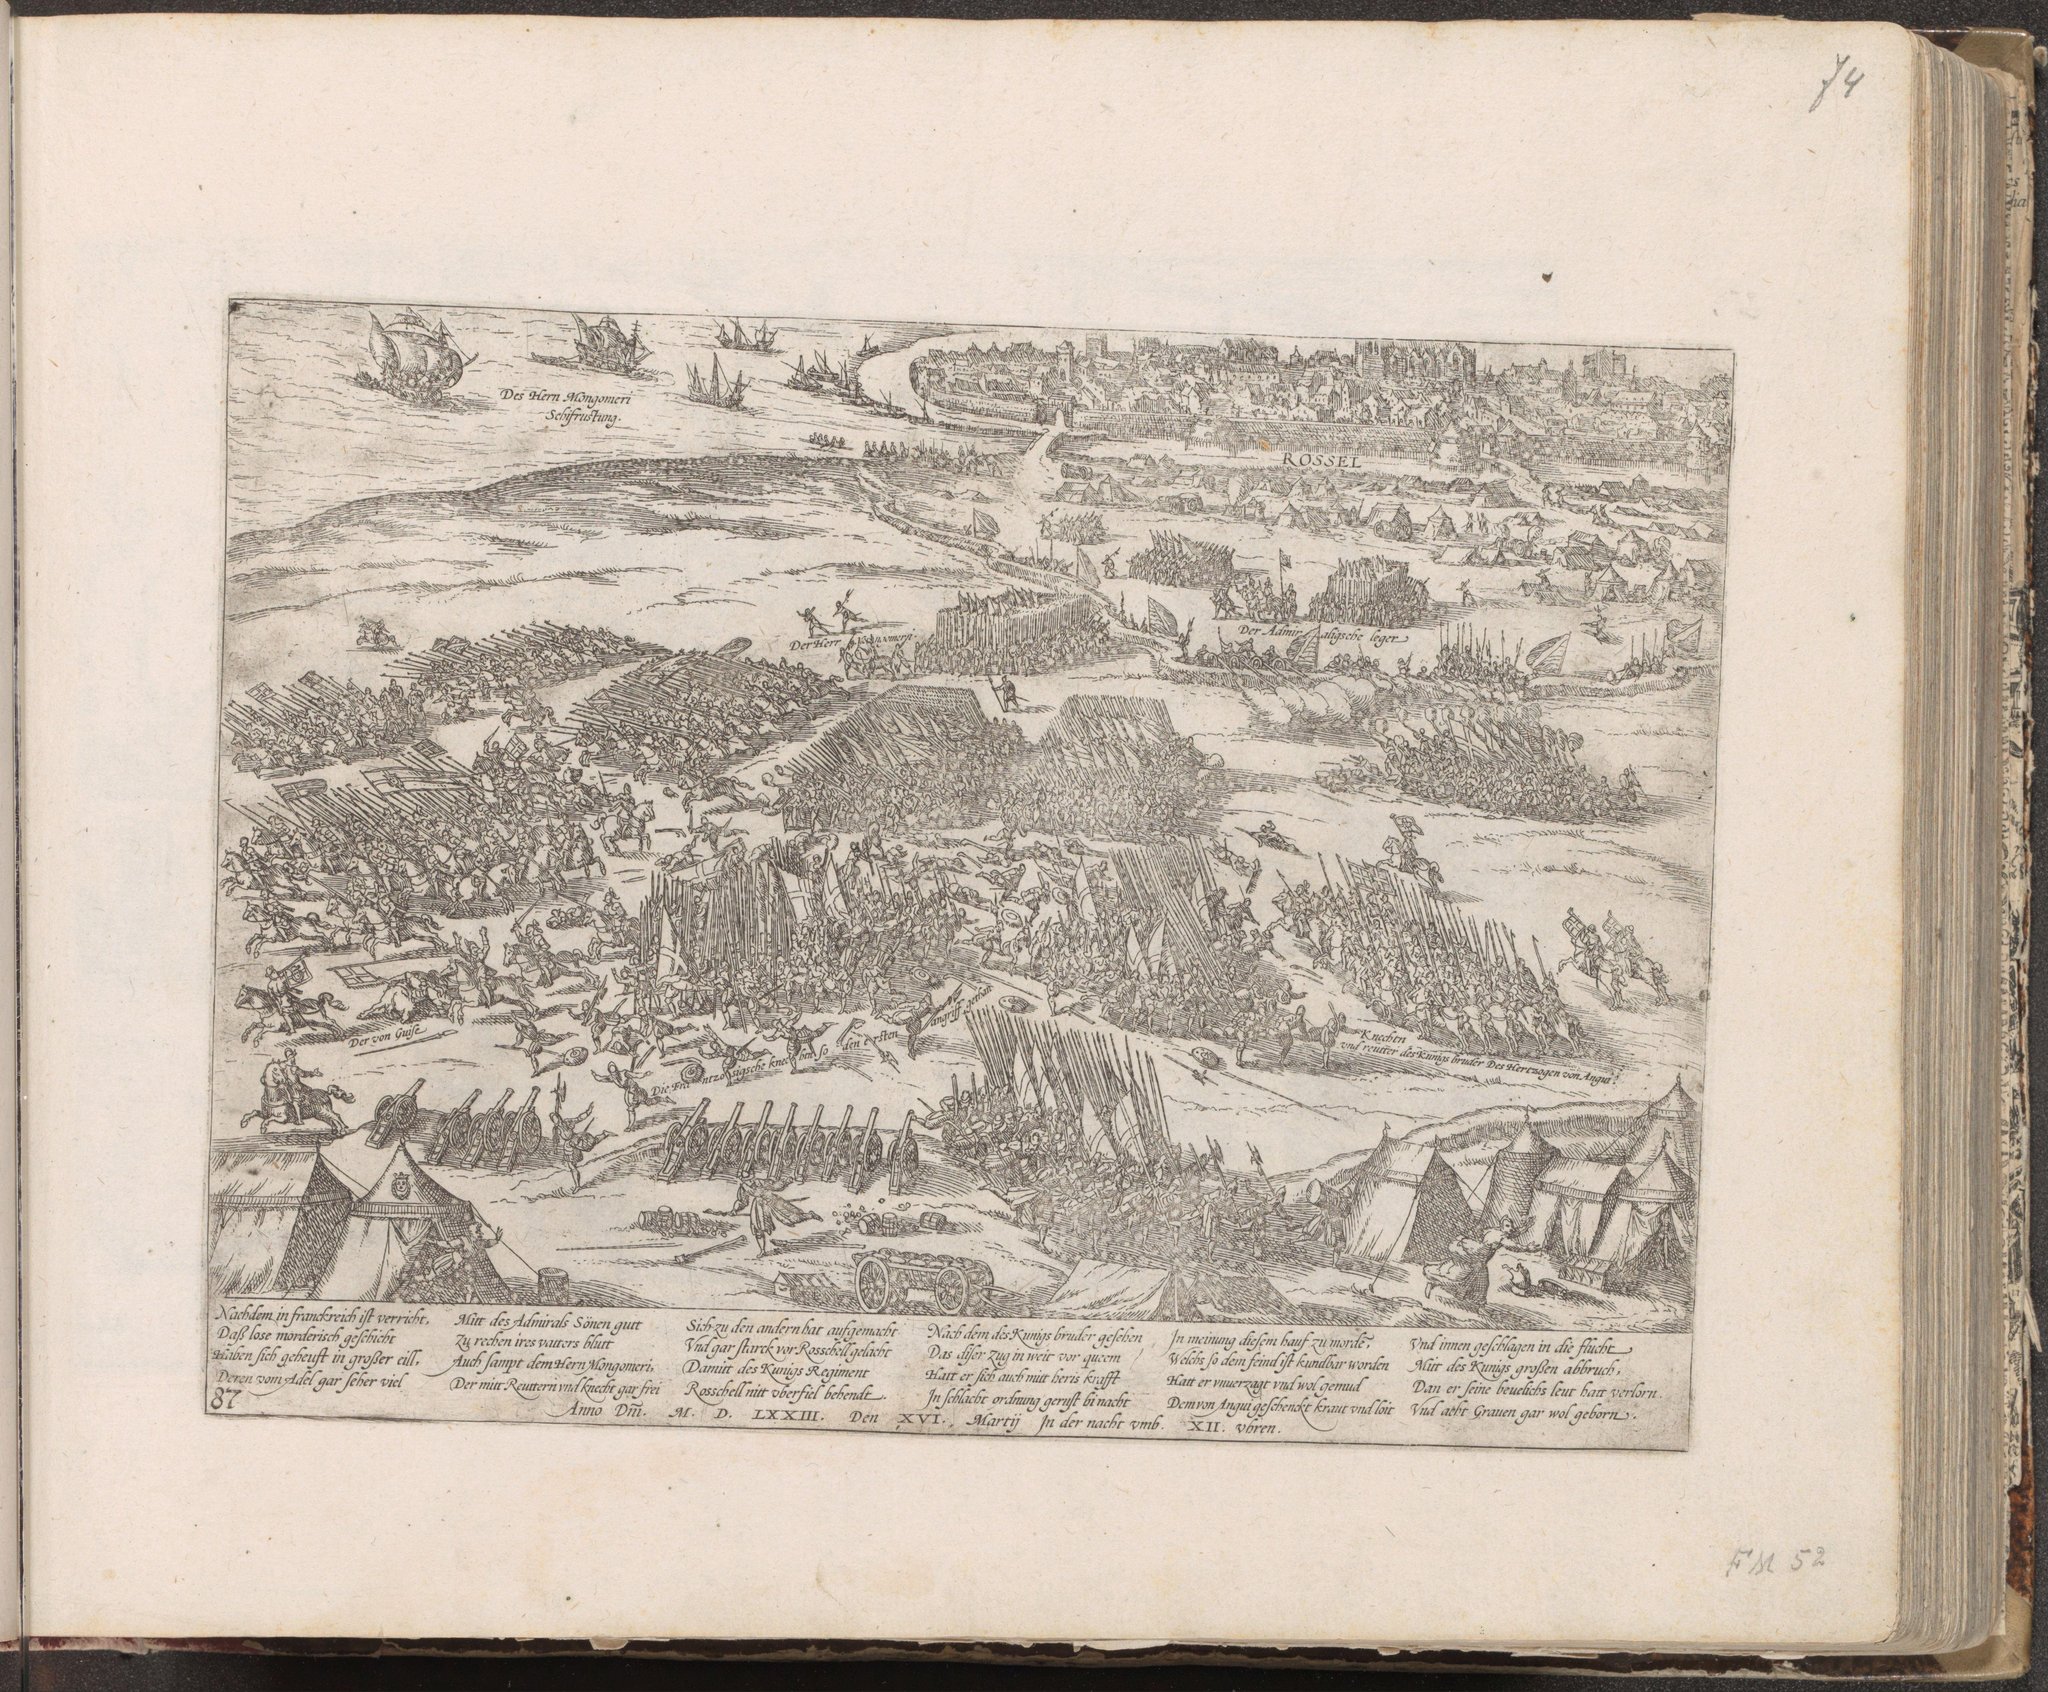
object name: history print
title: Verijdelde aanslag van de koning op La Rochelle, 1573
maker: frans hogenberg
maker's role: print maker, publisher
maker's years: 1538-1590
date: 1573-1574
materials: paper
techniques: etching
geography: cologne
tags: battle, fighting in general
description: Verijdelde aanslag van de troepen van de koning op de stad La Rochelle, in de nacht van 16 maart 1573. Gezicht op het slagveld, in de verte de stad la Rochelle. Met onderschrift van 24 regels in het Duits. Linksonder genummerd: 87. De prent maakt deel uit van een album.